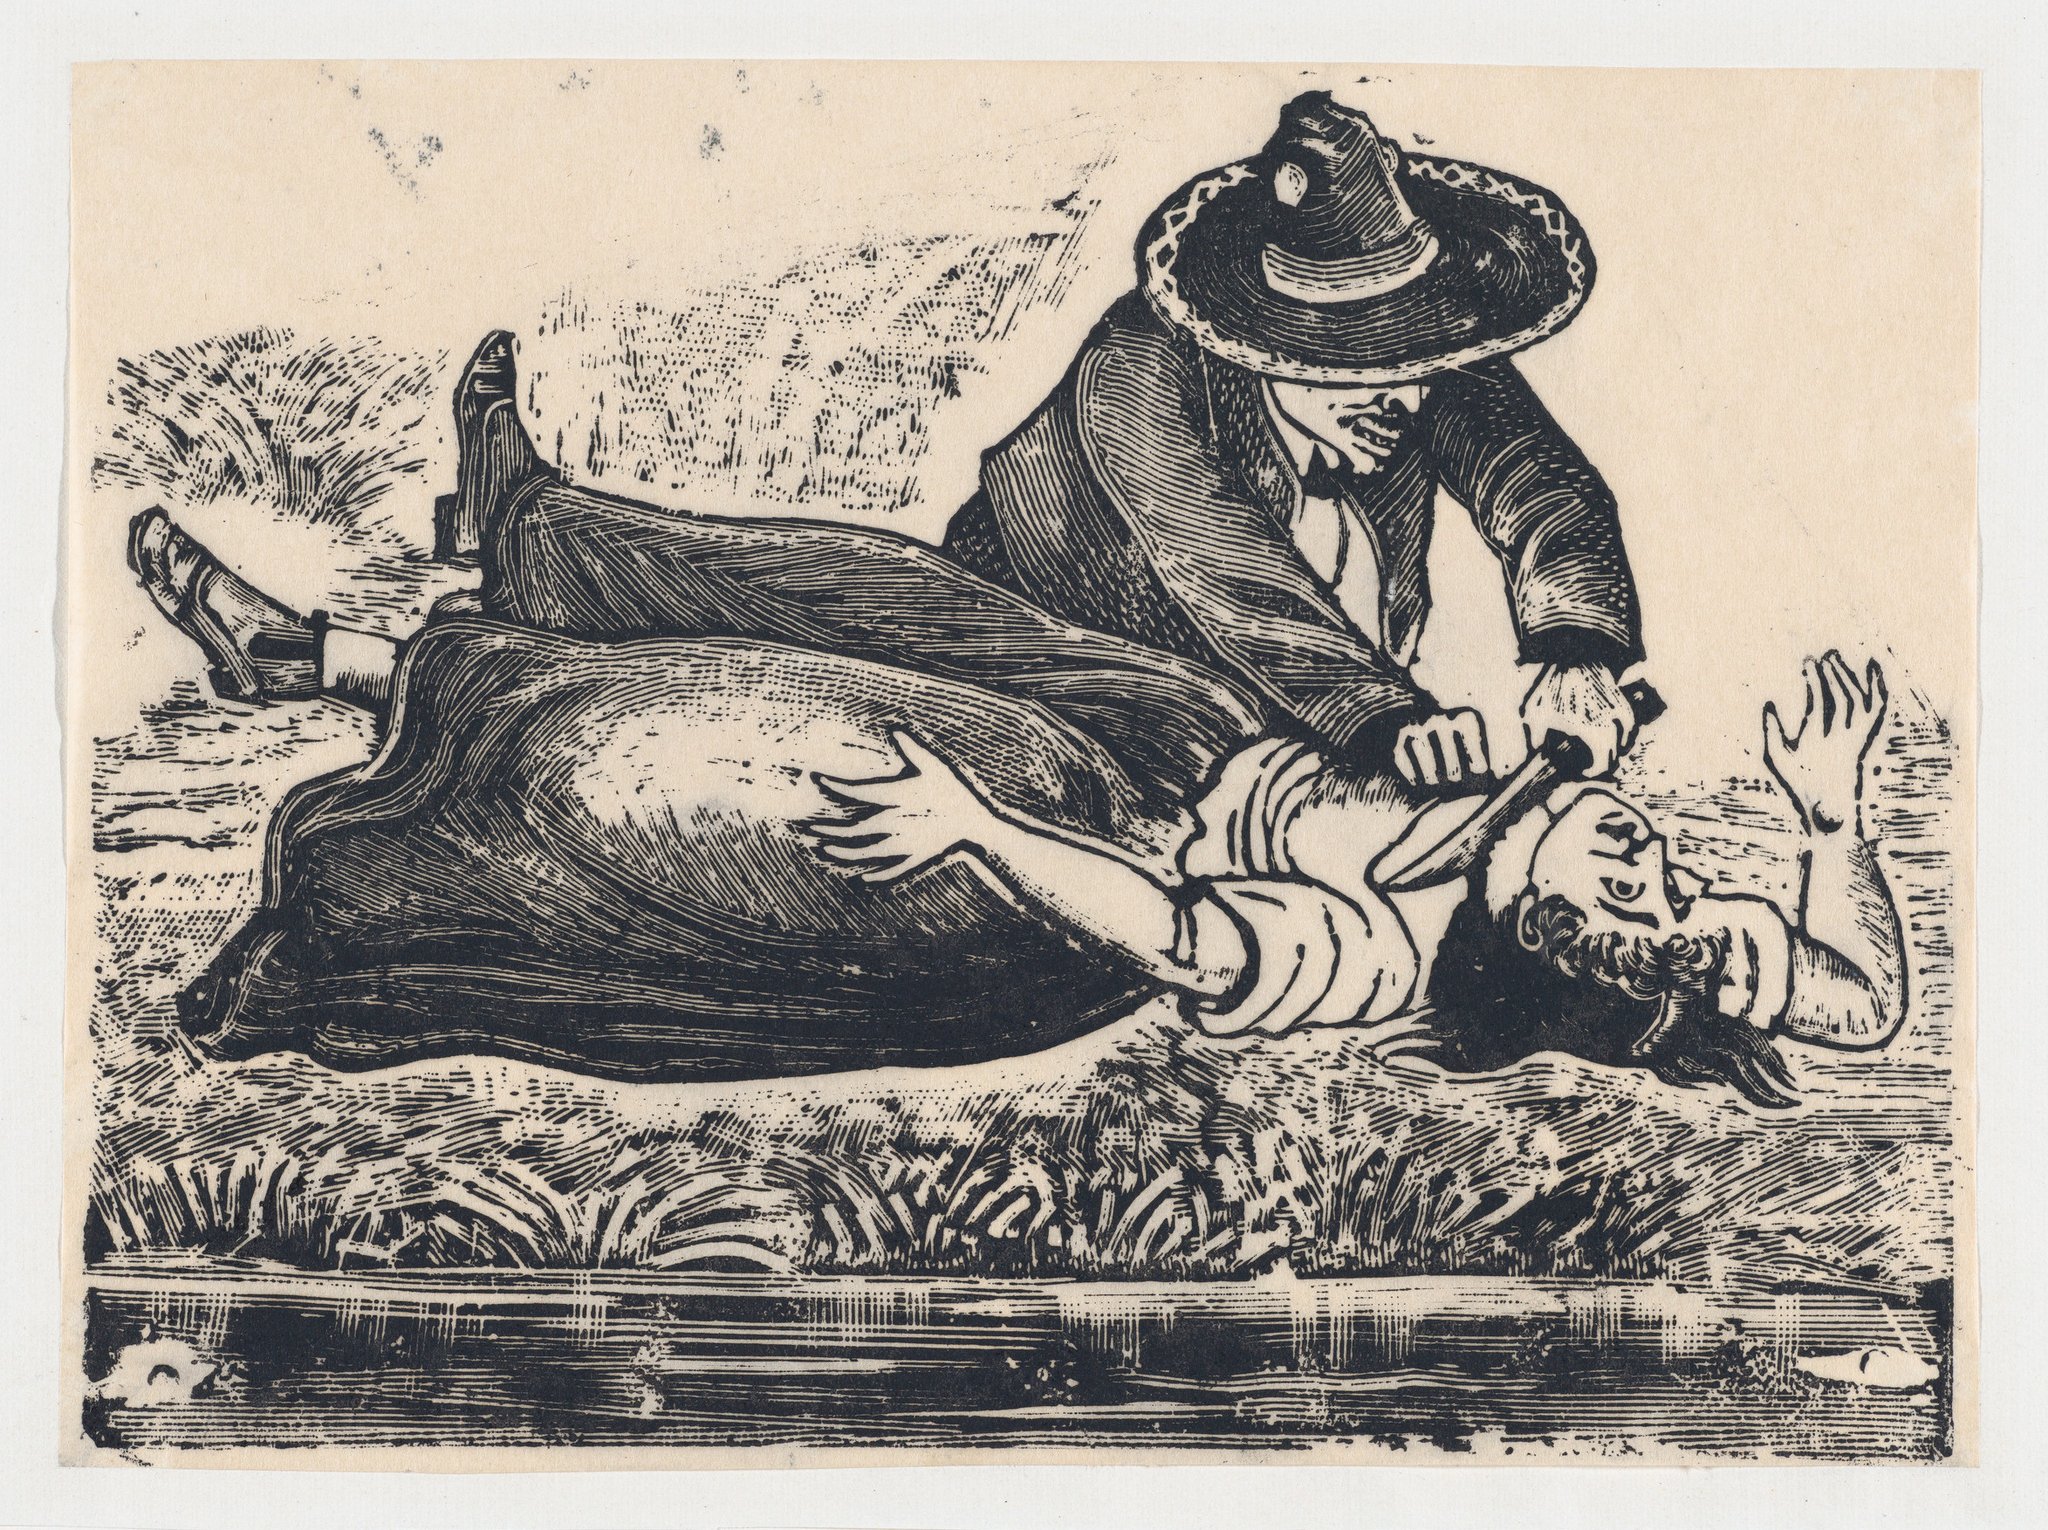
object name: print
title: Francisco Guerrero, the waistcoat maker and cut throat, murdering a woman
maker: josé guadalupe posada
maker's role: artist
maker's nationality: mexican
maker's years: 1852-1913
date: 1892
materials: metal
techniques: engraving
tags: suffering,men,women